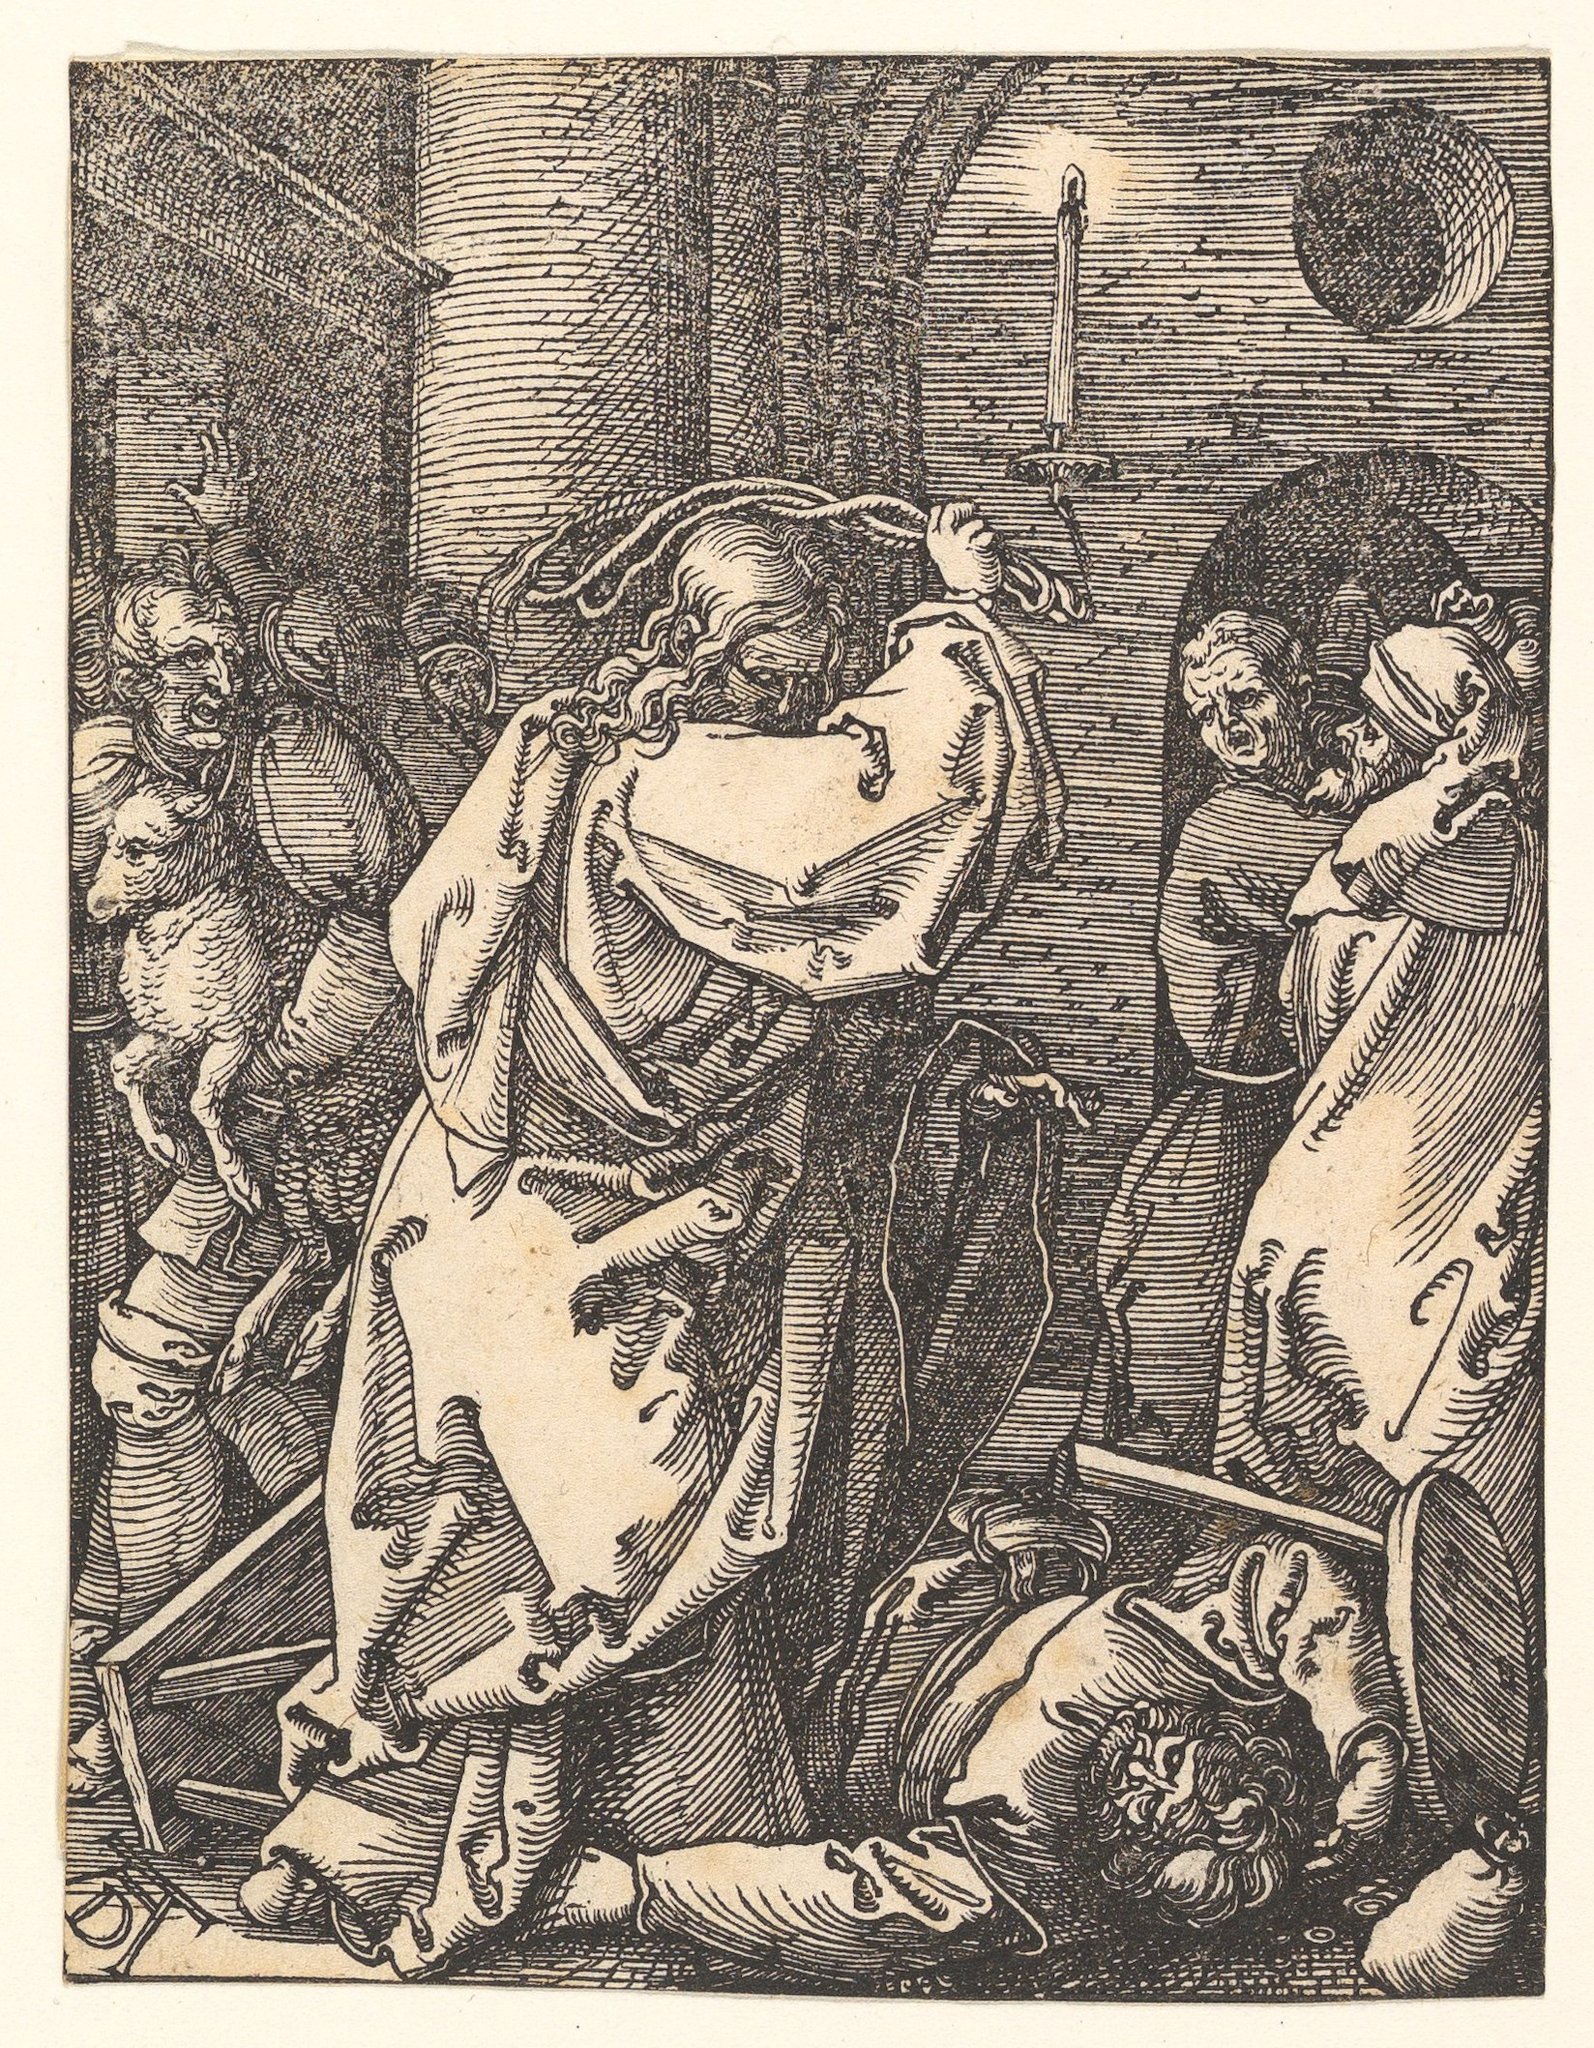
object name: print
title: Christ Expelling the Money Lenders, from "The Small Passion"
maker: albrecht dürer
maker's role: artist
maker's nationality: german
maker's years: 1471-1528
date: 1508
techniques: woodcut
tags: men,christ,punishment